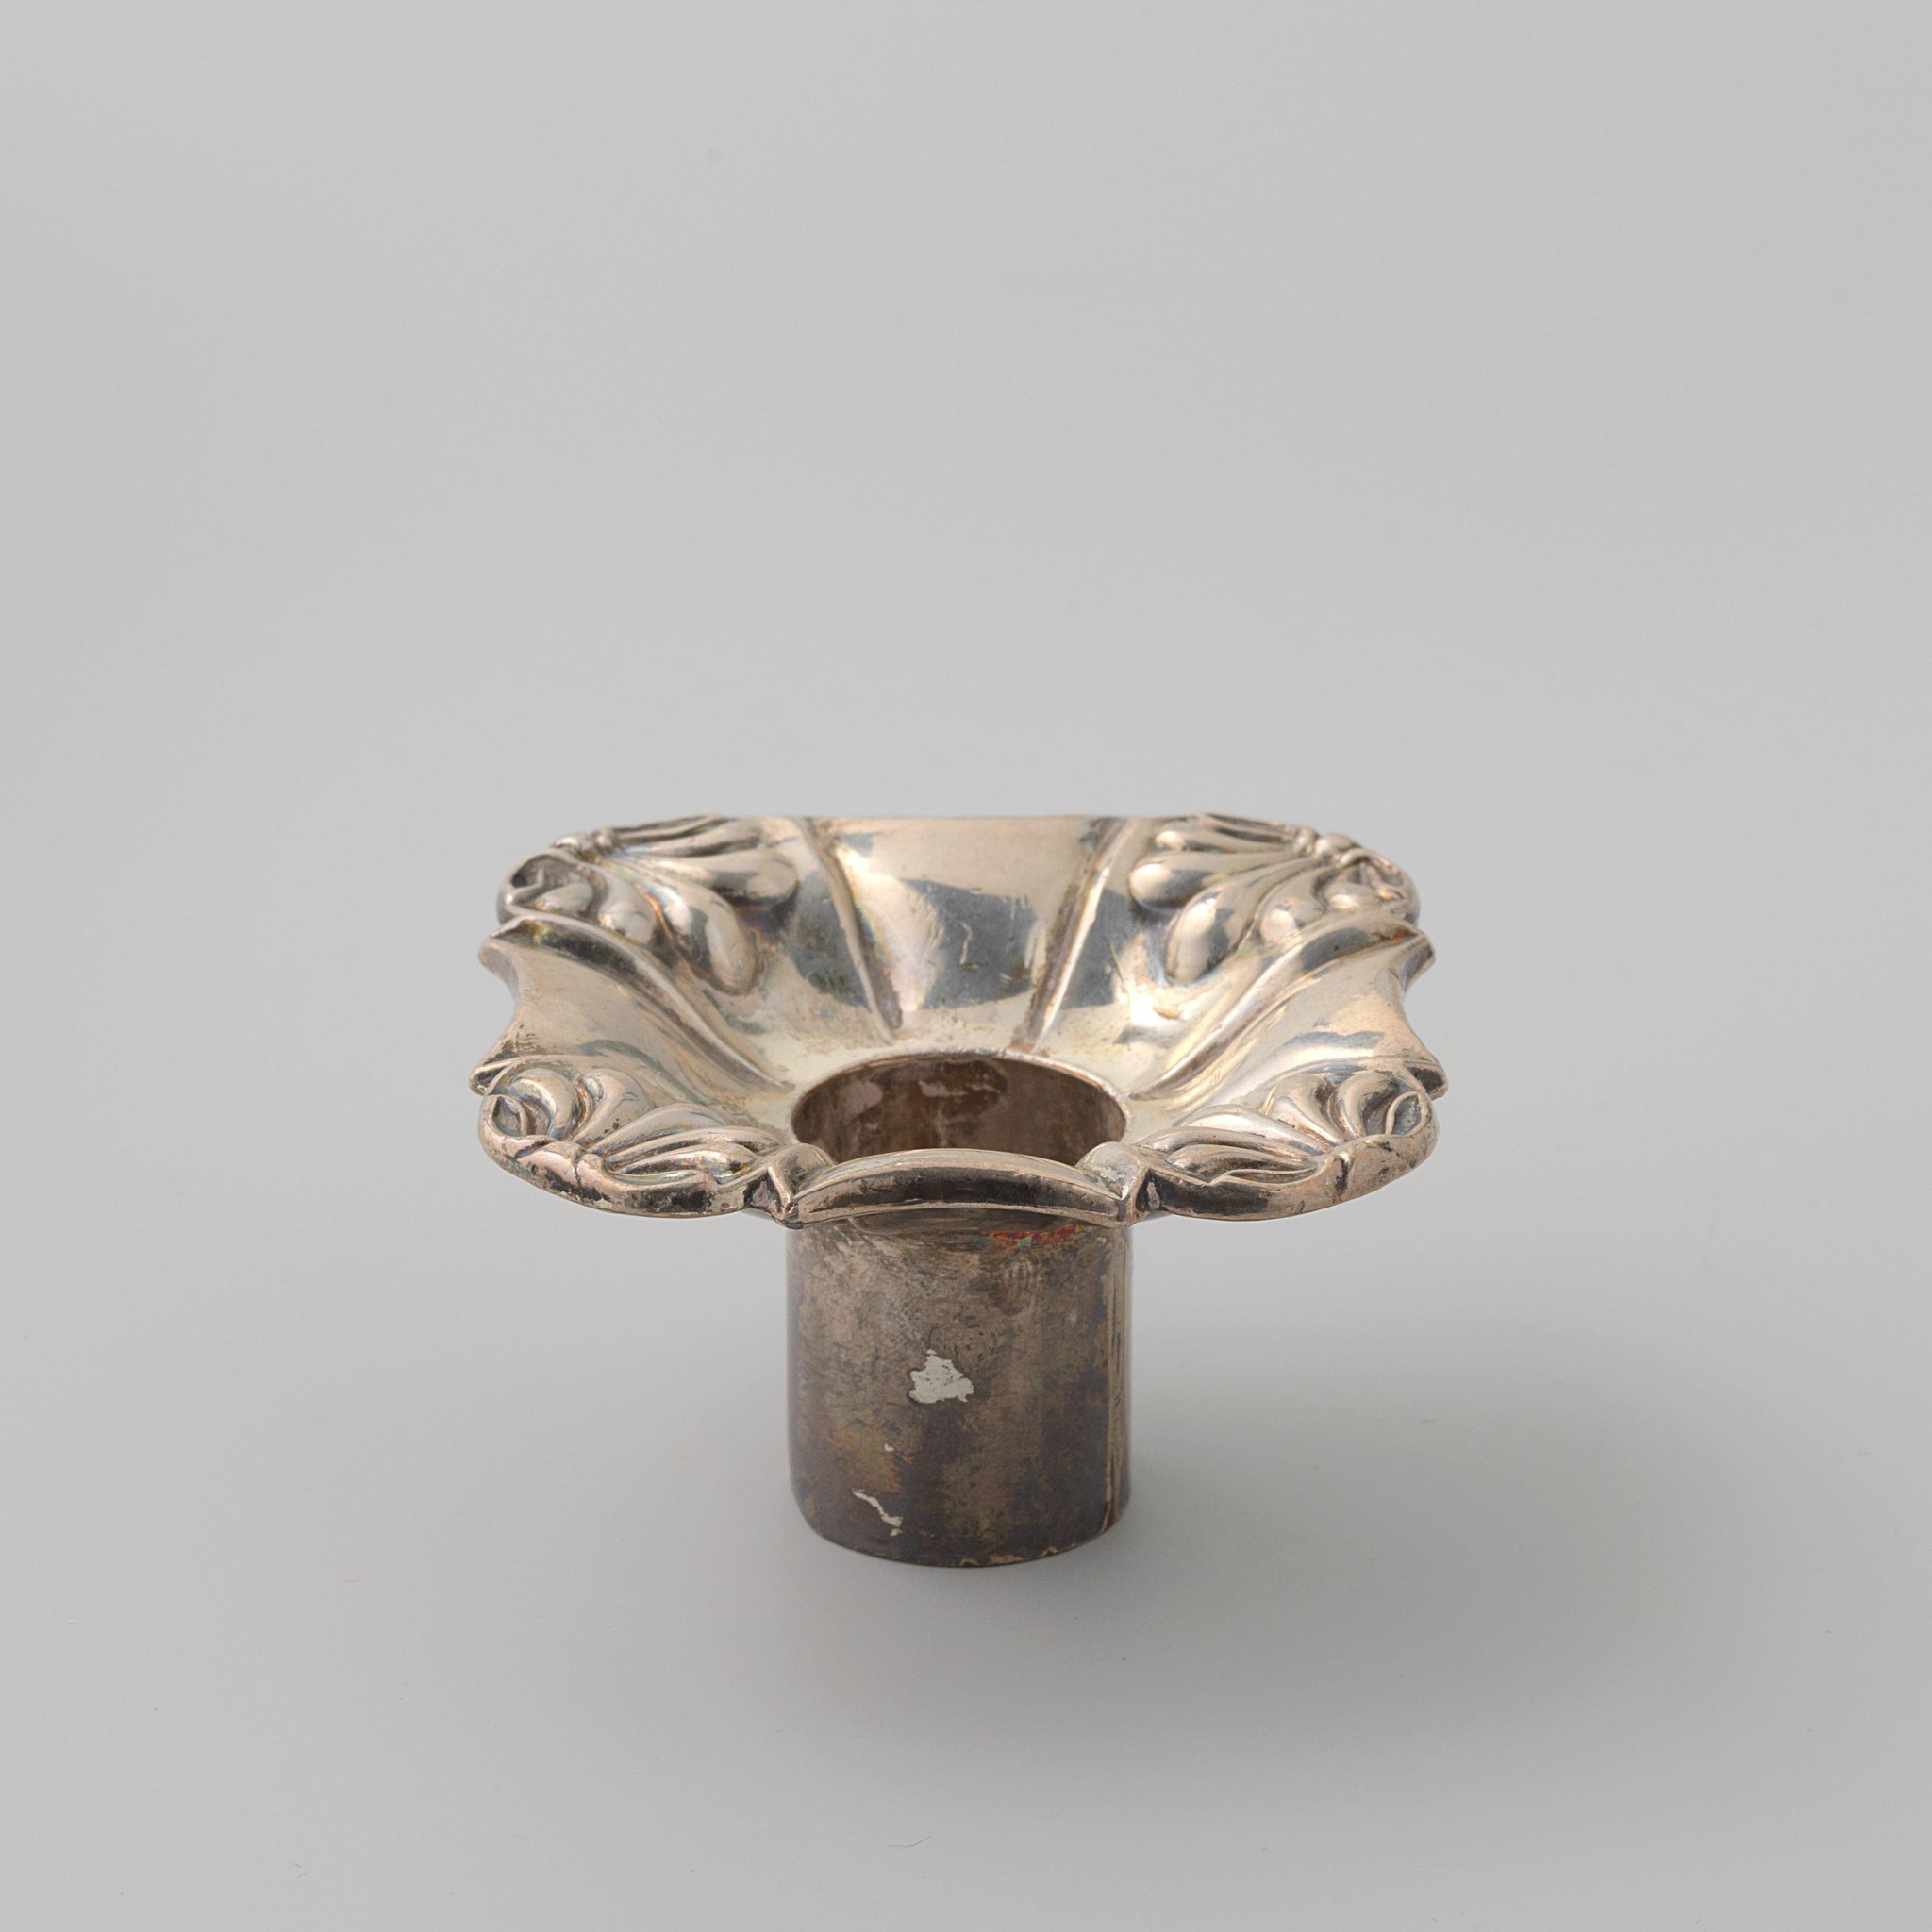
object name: bobeche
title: Vetvanger horend bij een kandelaber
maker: Anonymous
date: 1900-2000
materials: plate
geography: great britain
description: Losse vetvanger horend bij een kandelaber van plate. De vetvanger kan op de vierkante voet worden geplaatst om een kandelaar te vormen.